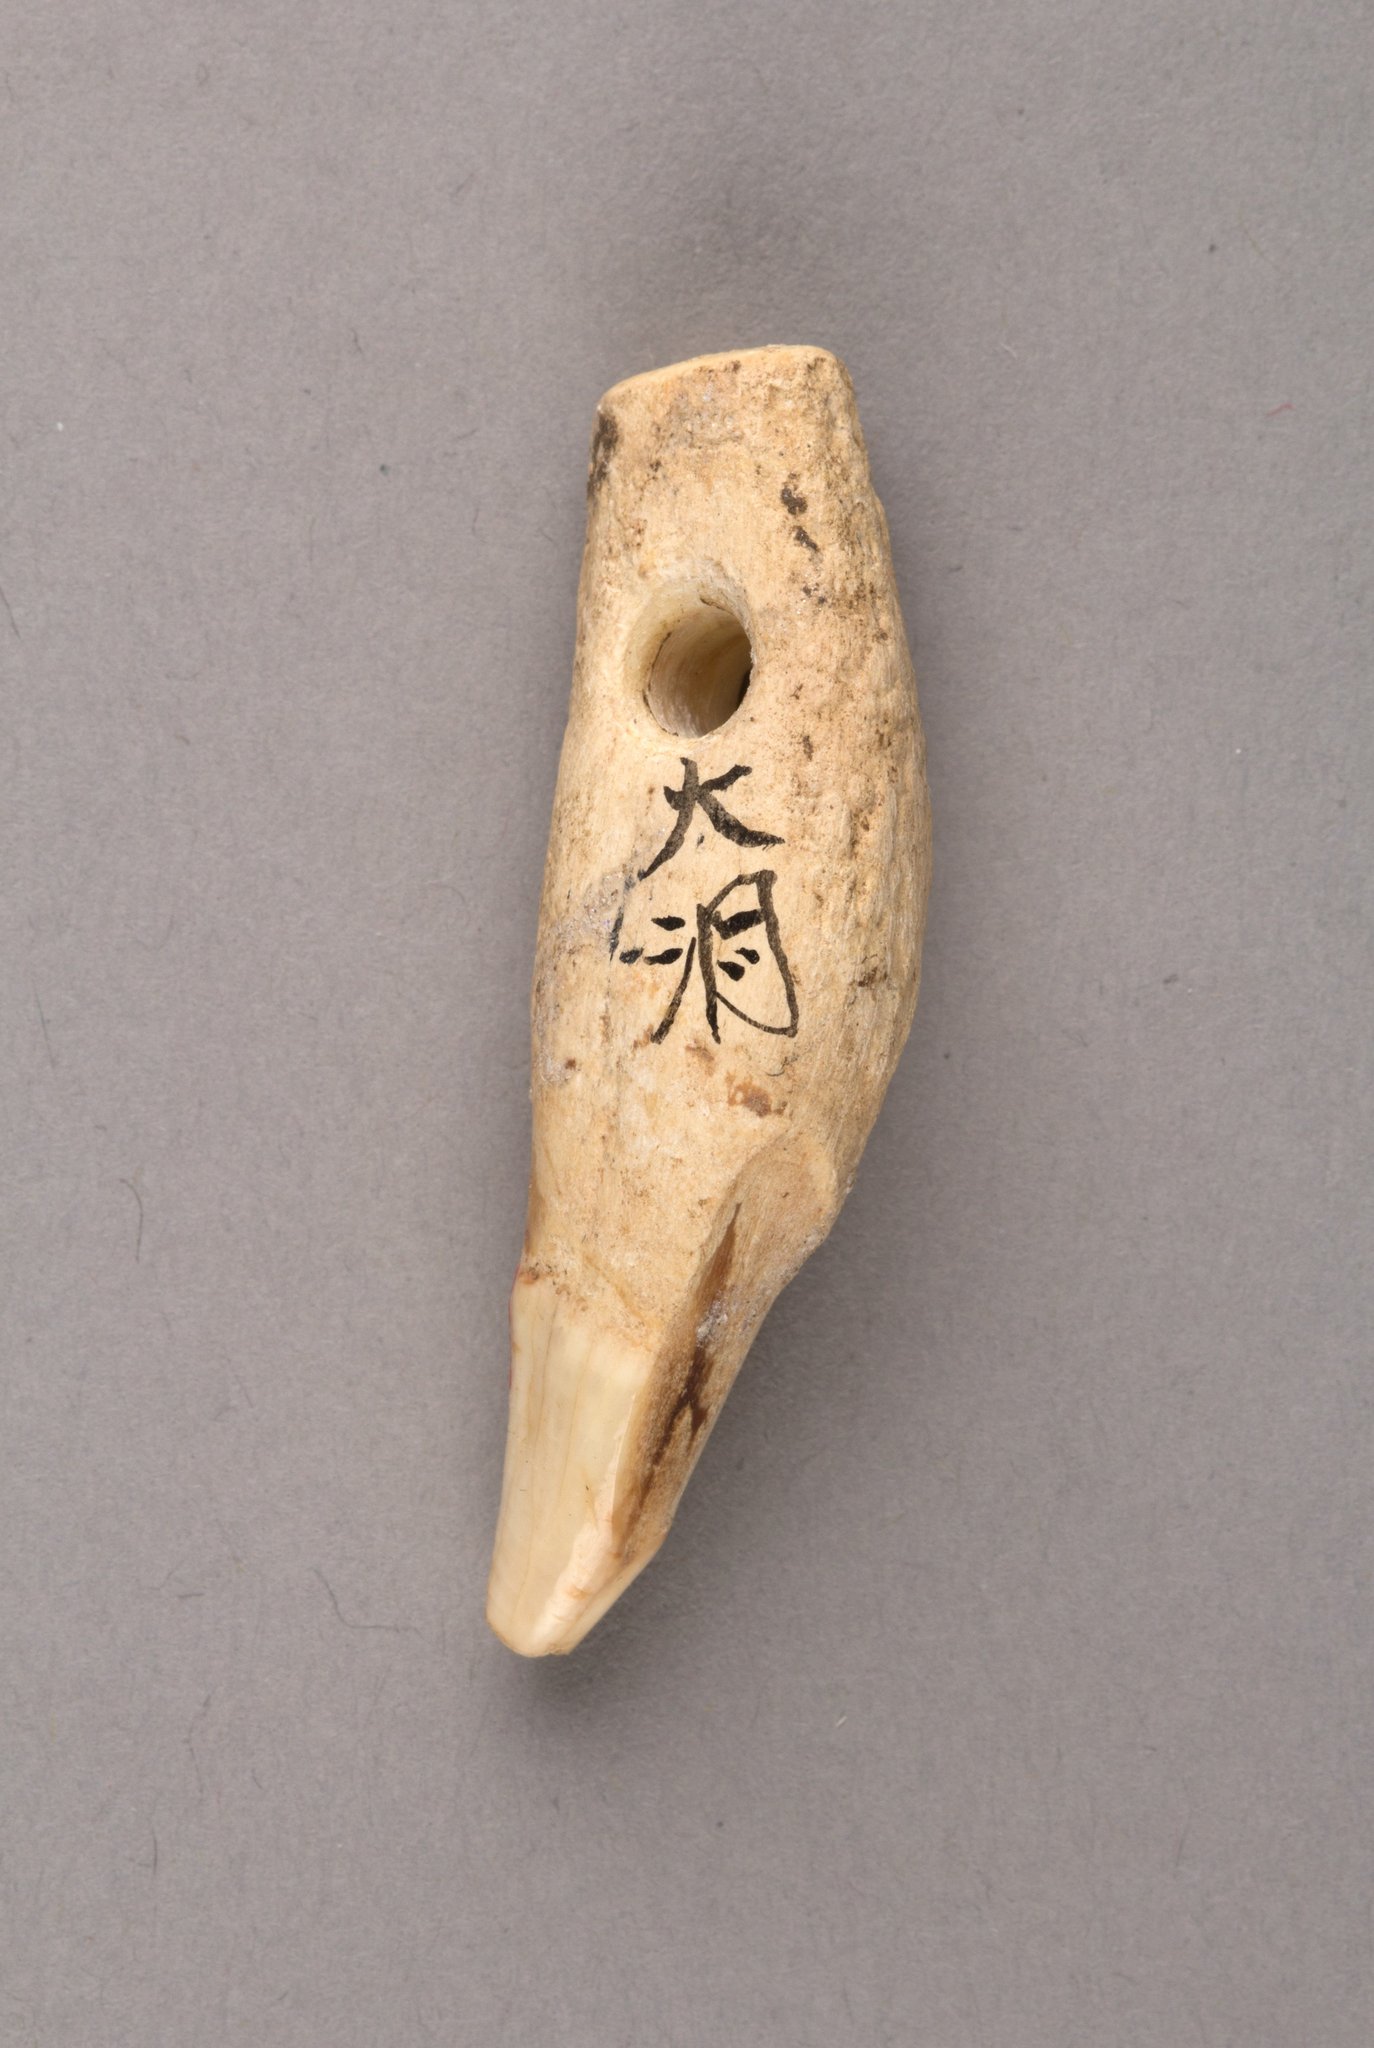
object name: body ornament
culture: japanese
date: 1000-300 BCE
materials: bone